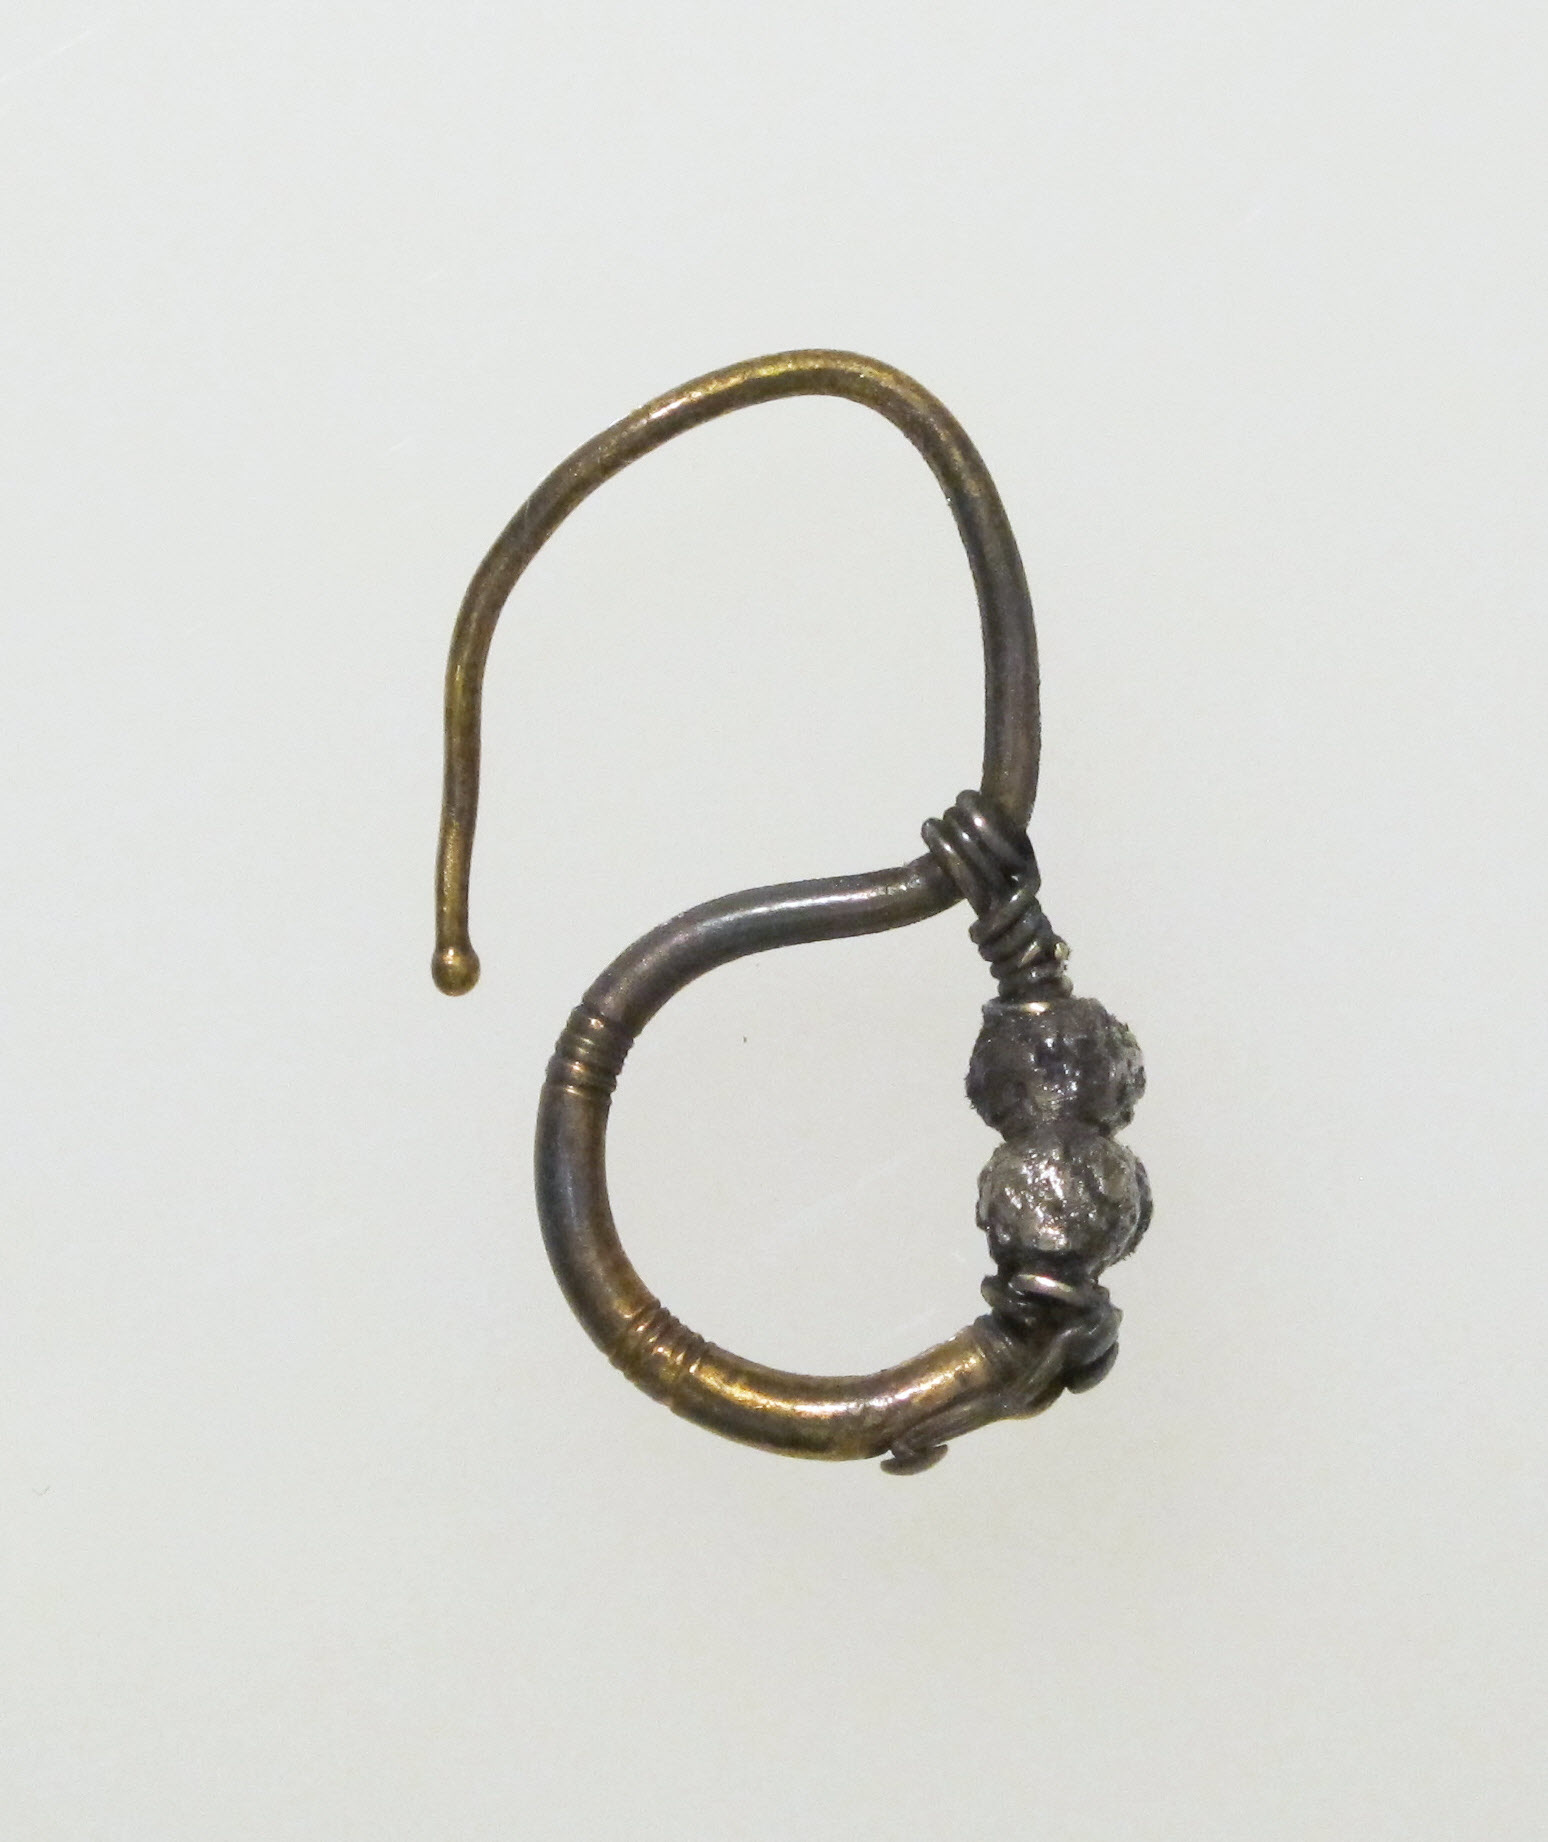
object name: earring, delta shaped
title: Earring, delta-shaped with beads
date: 7000 BCE-330 CE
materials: gold, silver